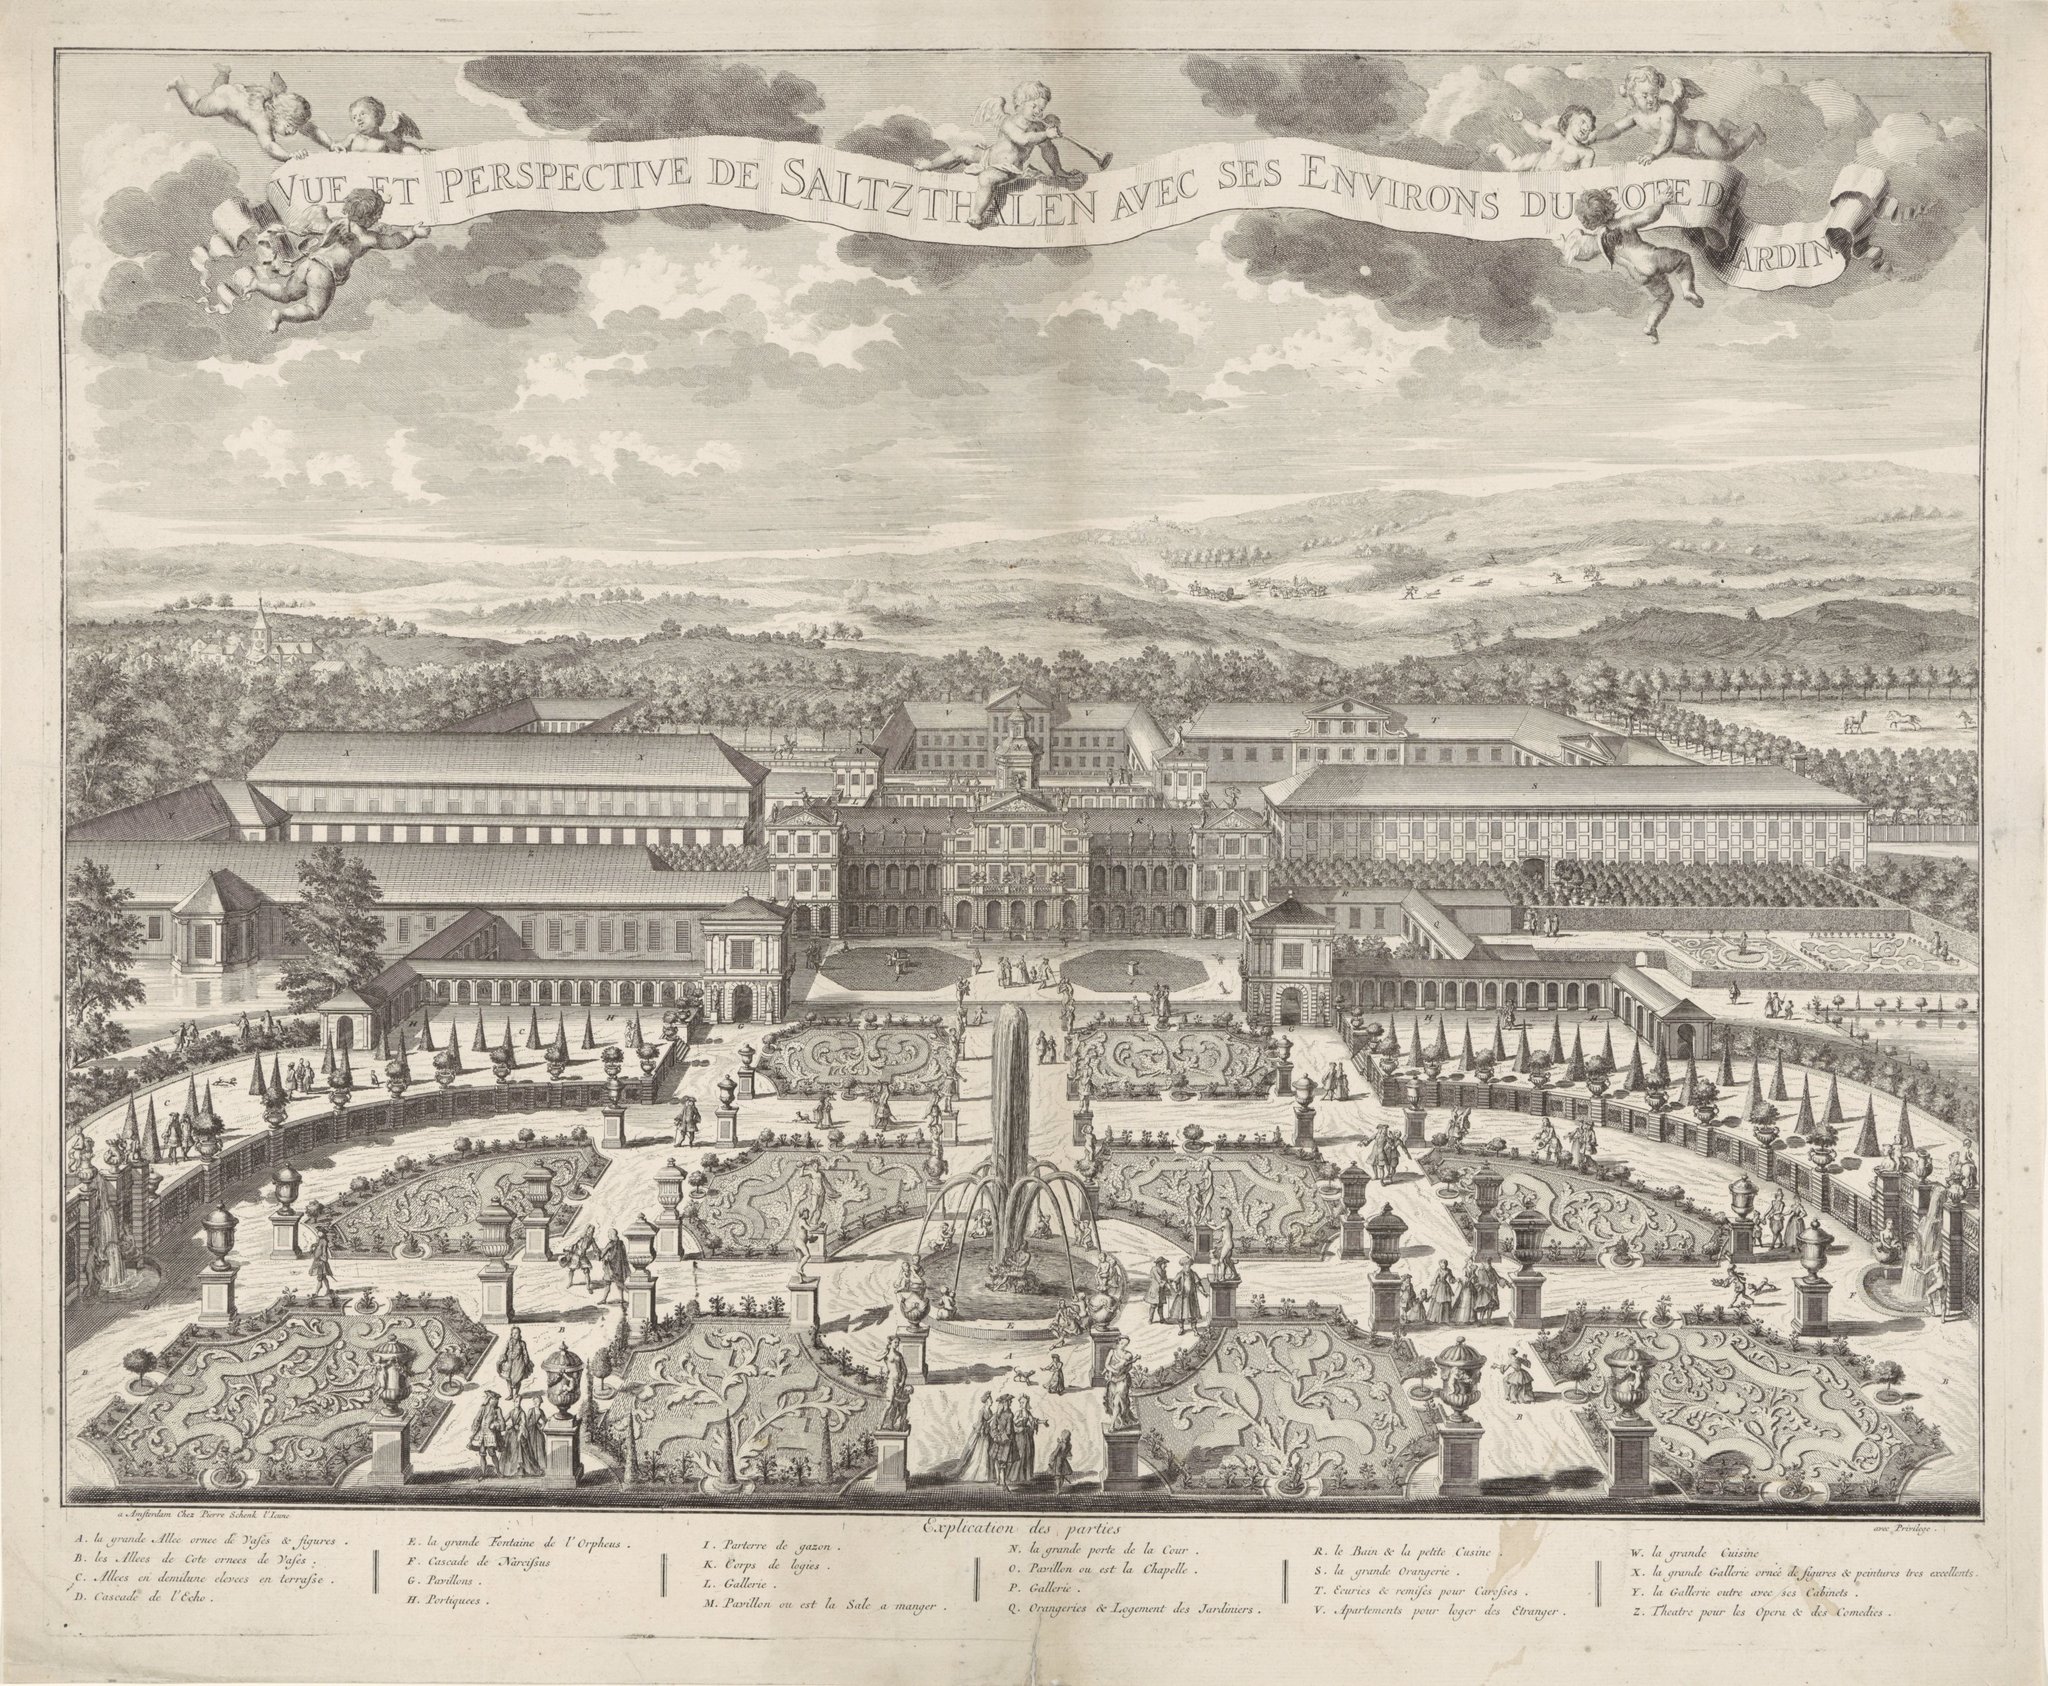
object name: print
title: Slot Saltzthalen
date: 1706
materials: paper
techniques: engraving, etching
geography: amsterdam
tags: hunting, chase, french or architectonic garden; formal garden, country-house, germany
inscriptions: collector's mark: Lugt 2228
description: Gezicht vanuit vogelperspectief op Slot Saltzthalen, vanaf de tuinzijde. Op de achtergrond bossen en velden, waar een jacht gaande is.